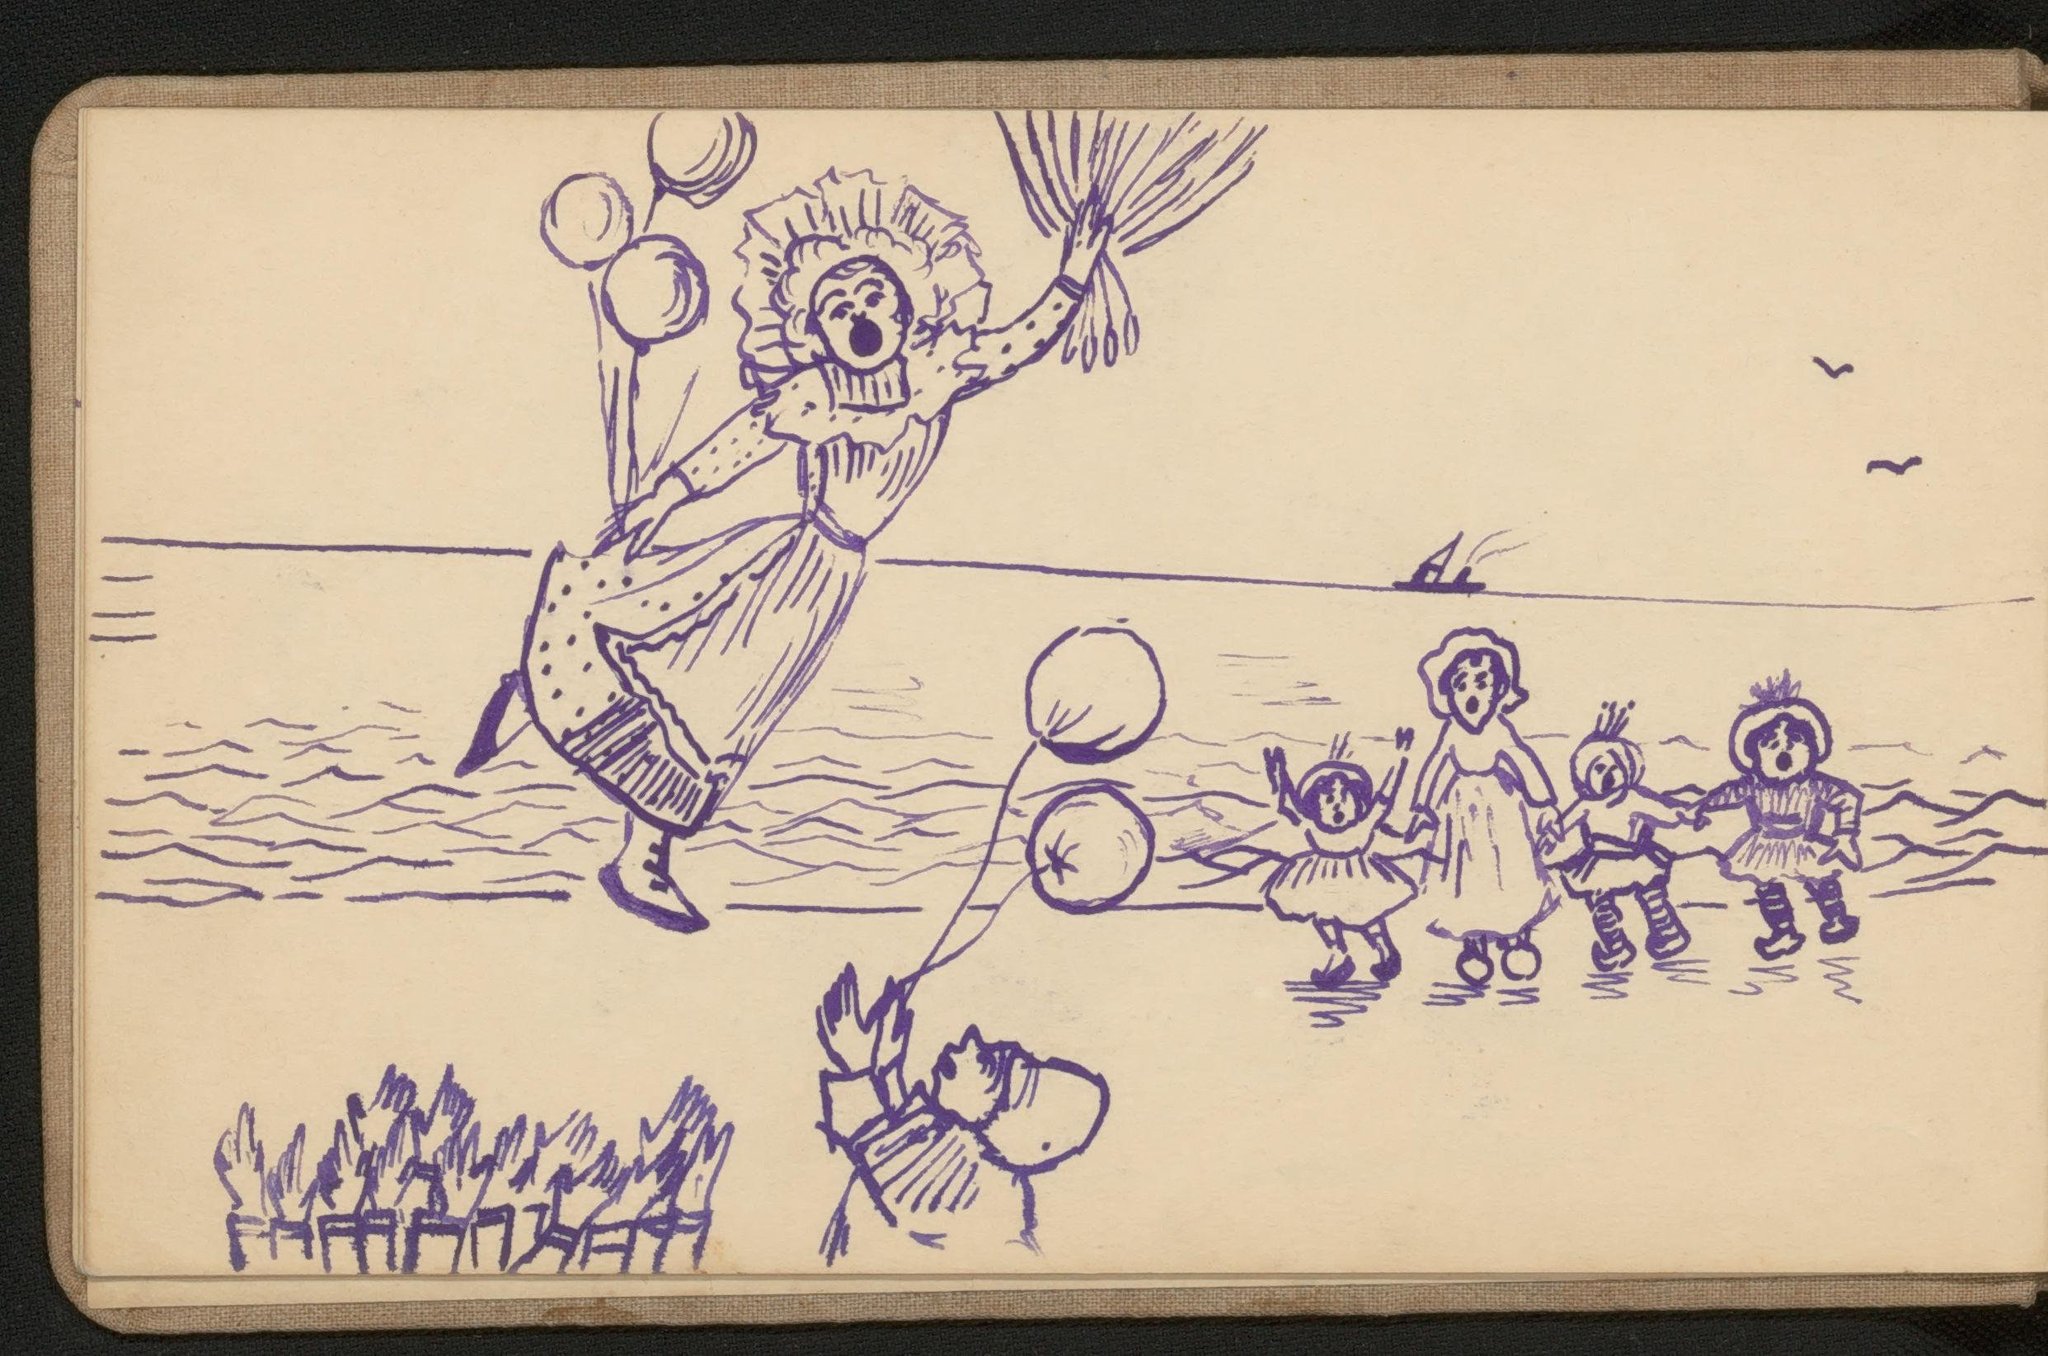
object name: sketchbook leaf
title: Moeder vliegt weg met ballonnen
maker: Anonymous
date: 1875-1920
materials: ink, paper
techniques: pen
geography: netherlands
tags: beach (as place of recreation), the family travelling, on holiday, (flying a) gas balloon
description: Moeder vliegt weg door de lucht met de ballonnen op het strand. Onderdeel van het schetsboek met humoristische tekeningen over het leven van een 'famille nombreuse'. Onderwerpsrubrieken binnen de Atlas Zeden en Gewoonten: Zeden en Gewoonten in Engeren Zin, Des menschen beging, midden en einde, Kinderleven.